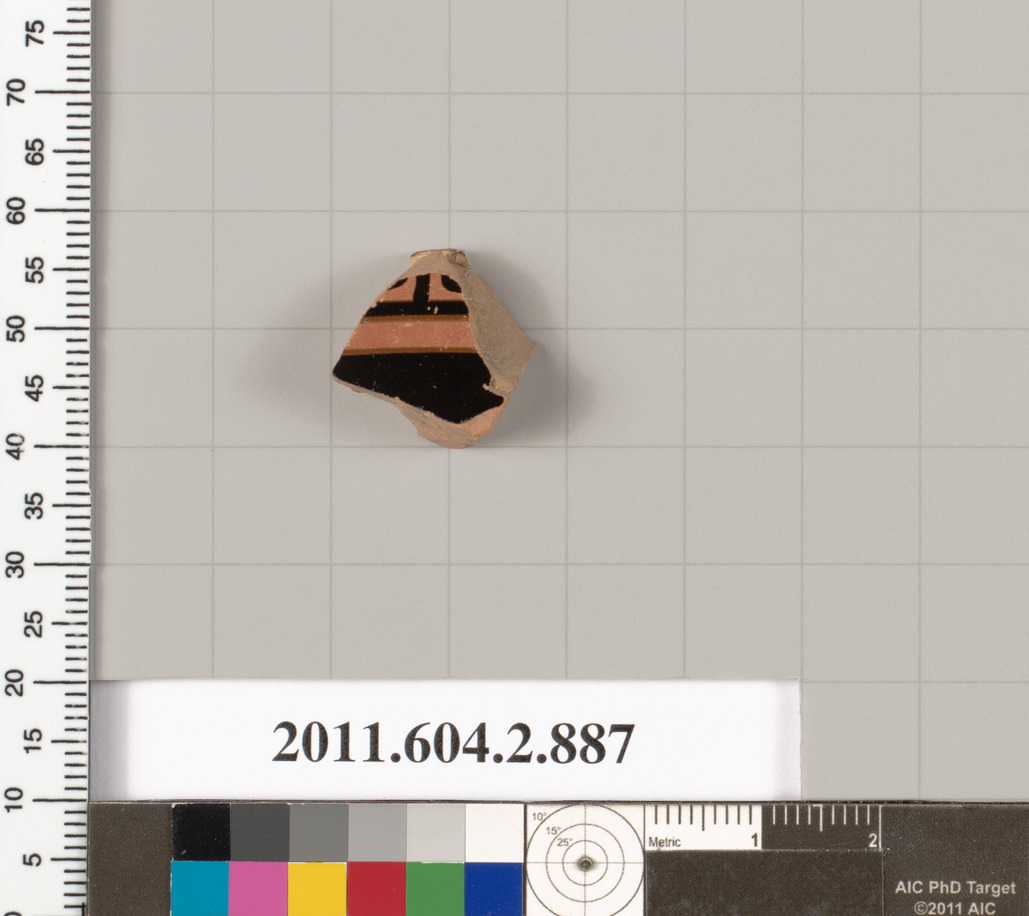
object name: bell krater fragment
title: Terracotta fragment of a bell-krater (bowl for mixing wine and water)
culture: greek, attic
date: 470-450 BCE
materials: terracotta